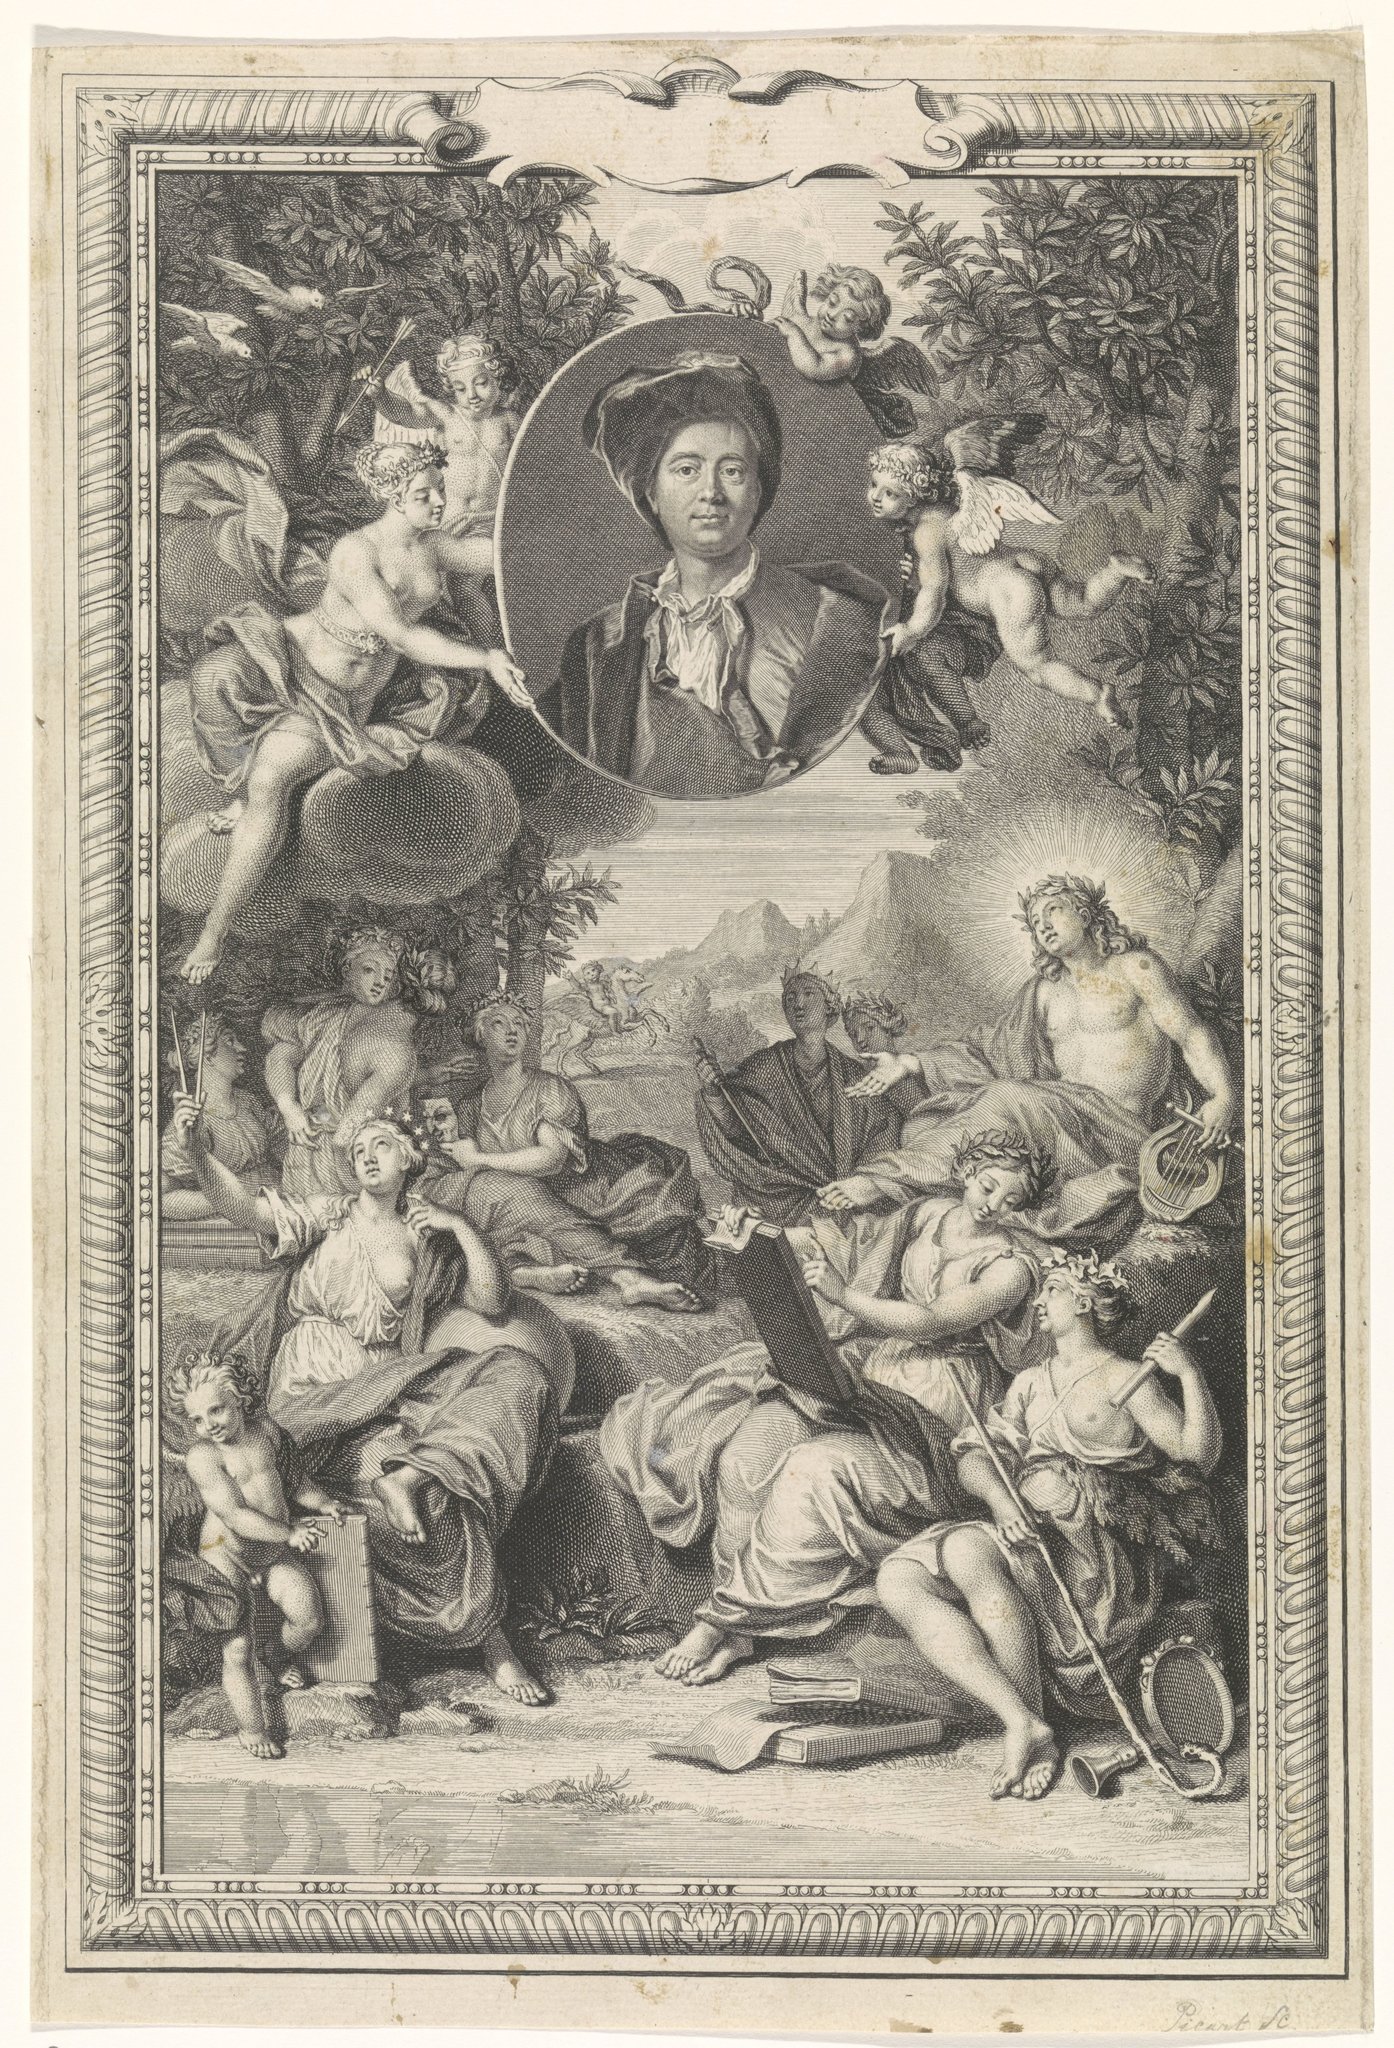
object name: print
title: Portret van Bernard de Fontenelle, met personificaties van de zeven vrije kunsten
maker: bernard picart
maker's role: draughtsman, print maker, publisher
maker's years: 1673-1733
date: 1727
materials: paper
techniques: engraving, etching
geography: amsterdam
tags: the liberal arts, 'artes liberales', portrait of a writer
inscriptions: collector's mark: Lugt 2228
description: Landschap met de vrouwelijke personificaties van de zeven vrije kunsten. Boven hen vliegen putti die het portret van de schrijver Bernard de Fontenelle dragen. Op de achtergrond een putto op de rug van Pegasus. De voorstelling is gevat in een omlijsting die wordt bekroond door een leeg cartouche.